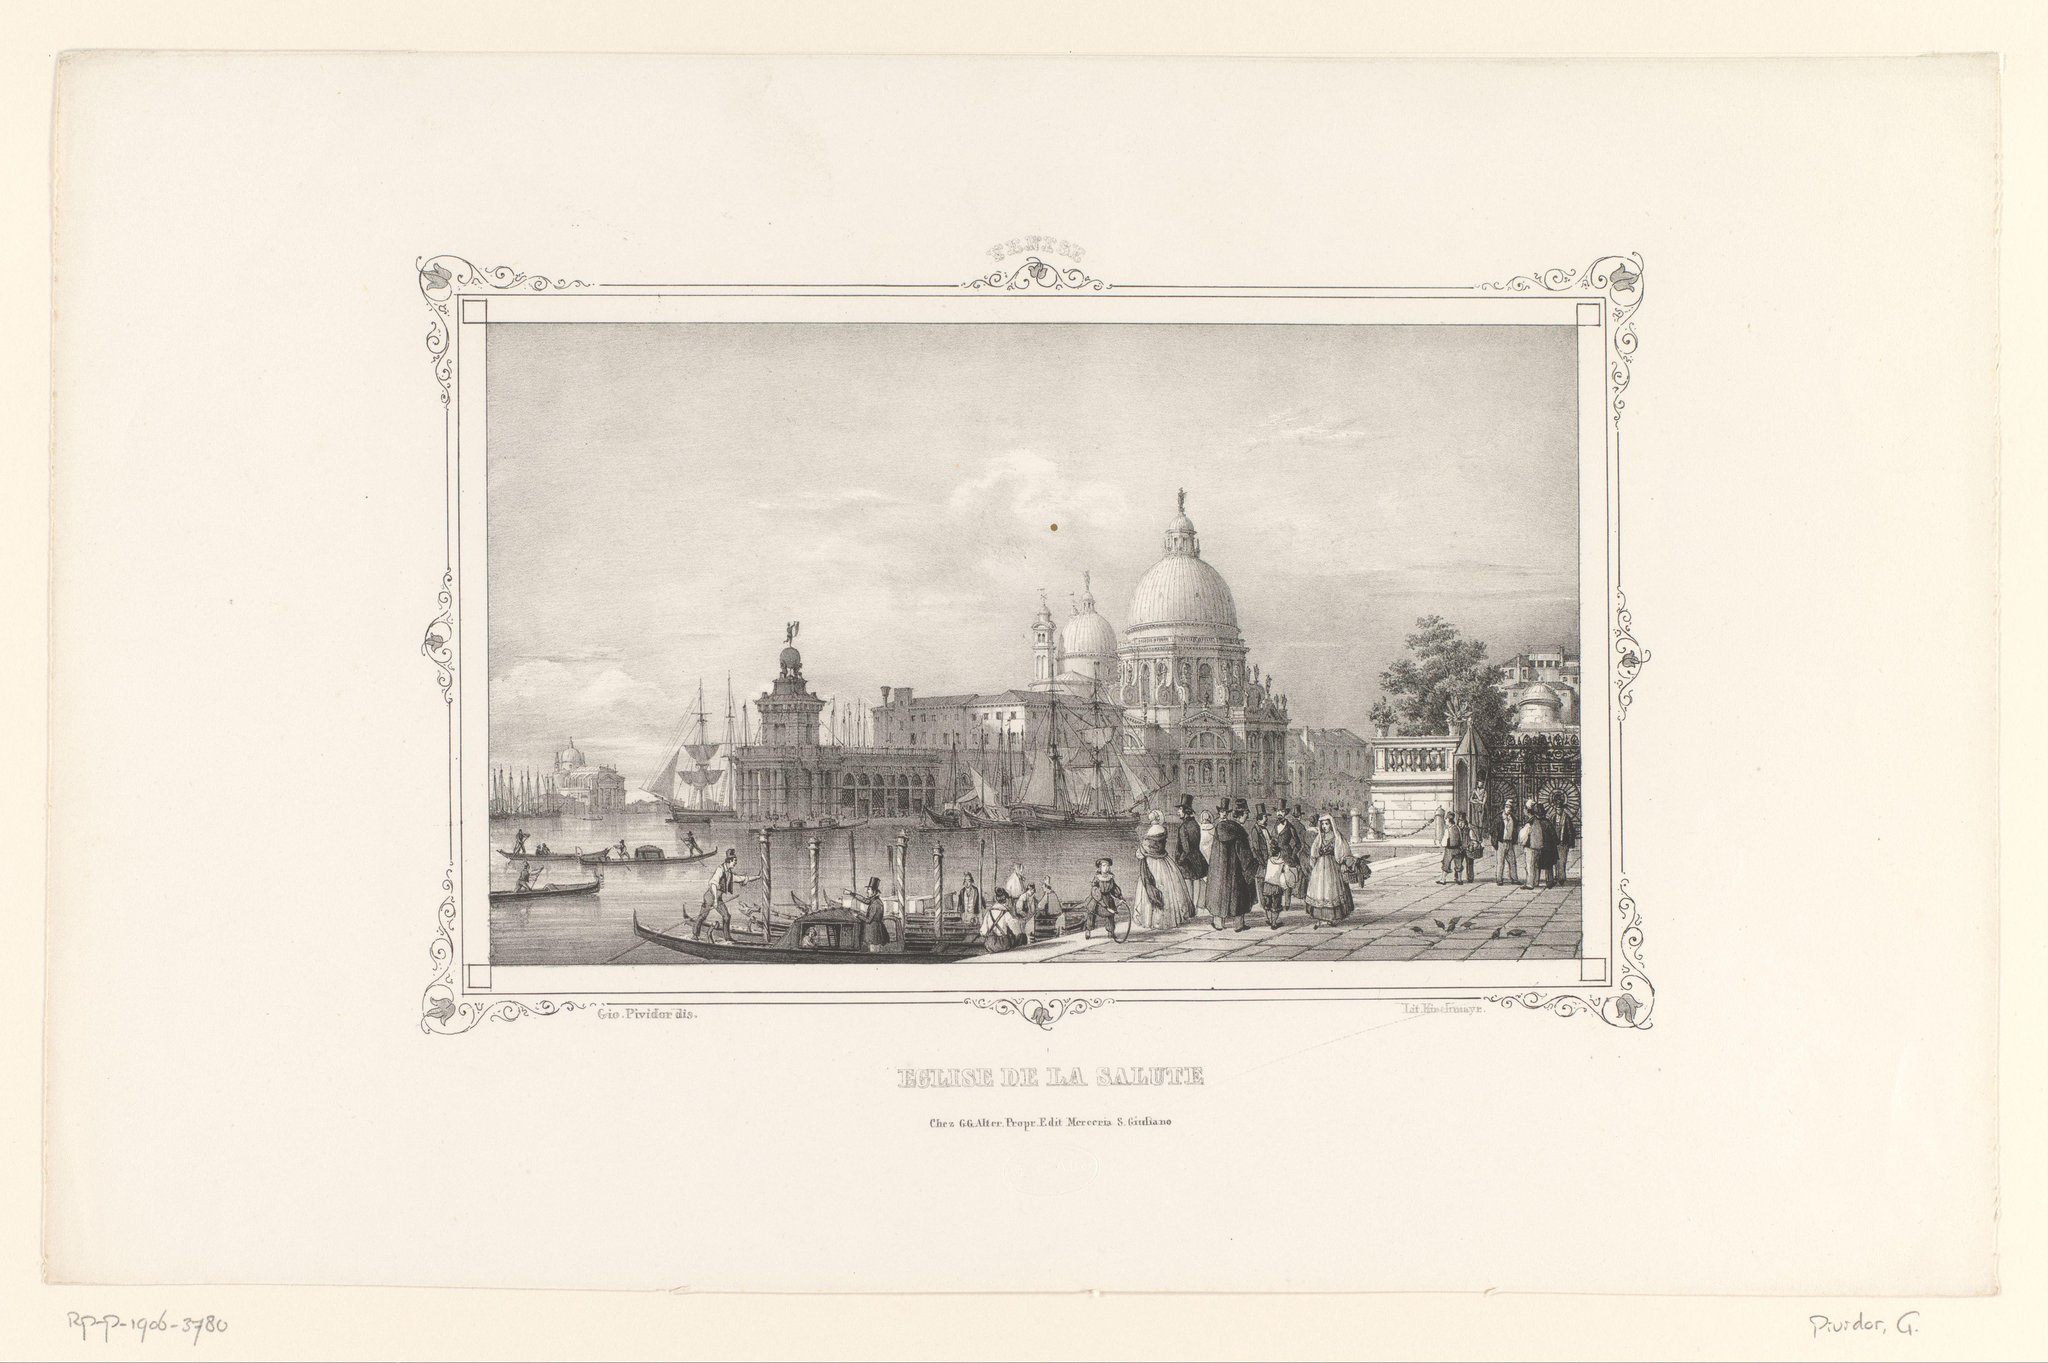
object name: print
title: Vedute dei monumenti classici di Venezia/ Haupt-Ansichten und Gebäude von Venedig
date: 1826-1872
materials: paper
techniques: lithograph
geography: venice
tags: city-view, and landscape with man-made constructions, church (exterior), canals, waters (in city)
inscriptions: collector's mark: ‘G.G. Alter’, collector's mark: Lugt 2228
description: Gezicht op de Santa Maria della Salute aan het Canal Grande te Venetië. Voorstelling is gevat in een sierlijst. Titel in het Frans onder de voorstelling.